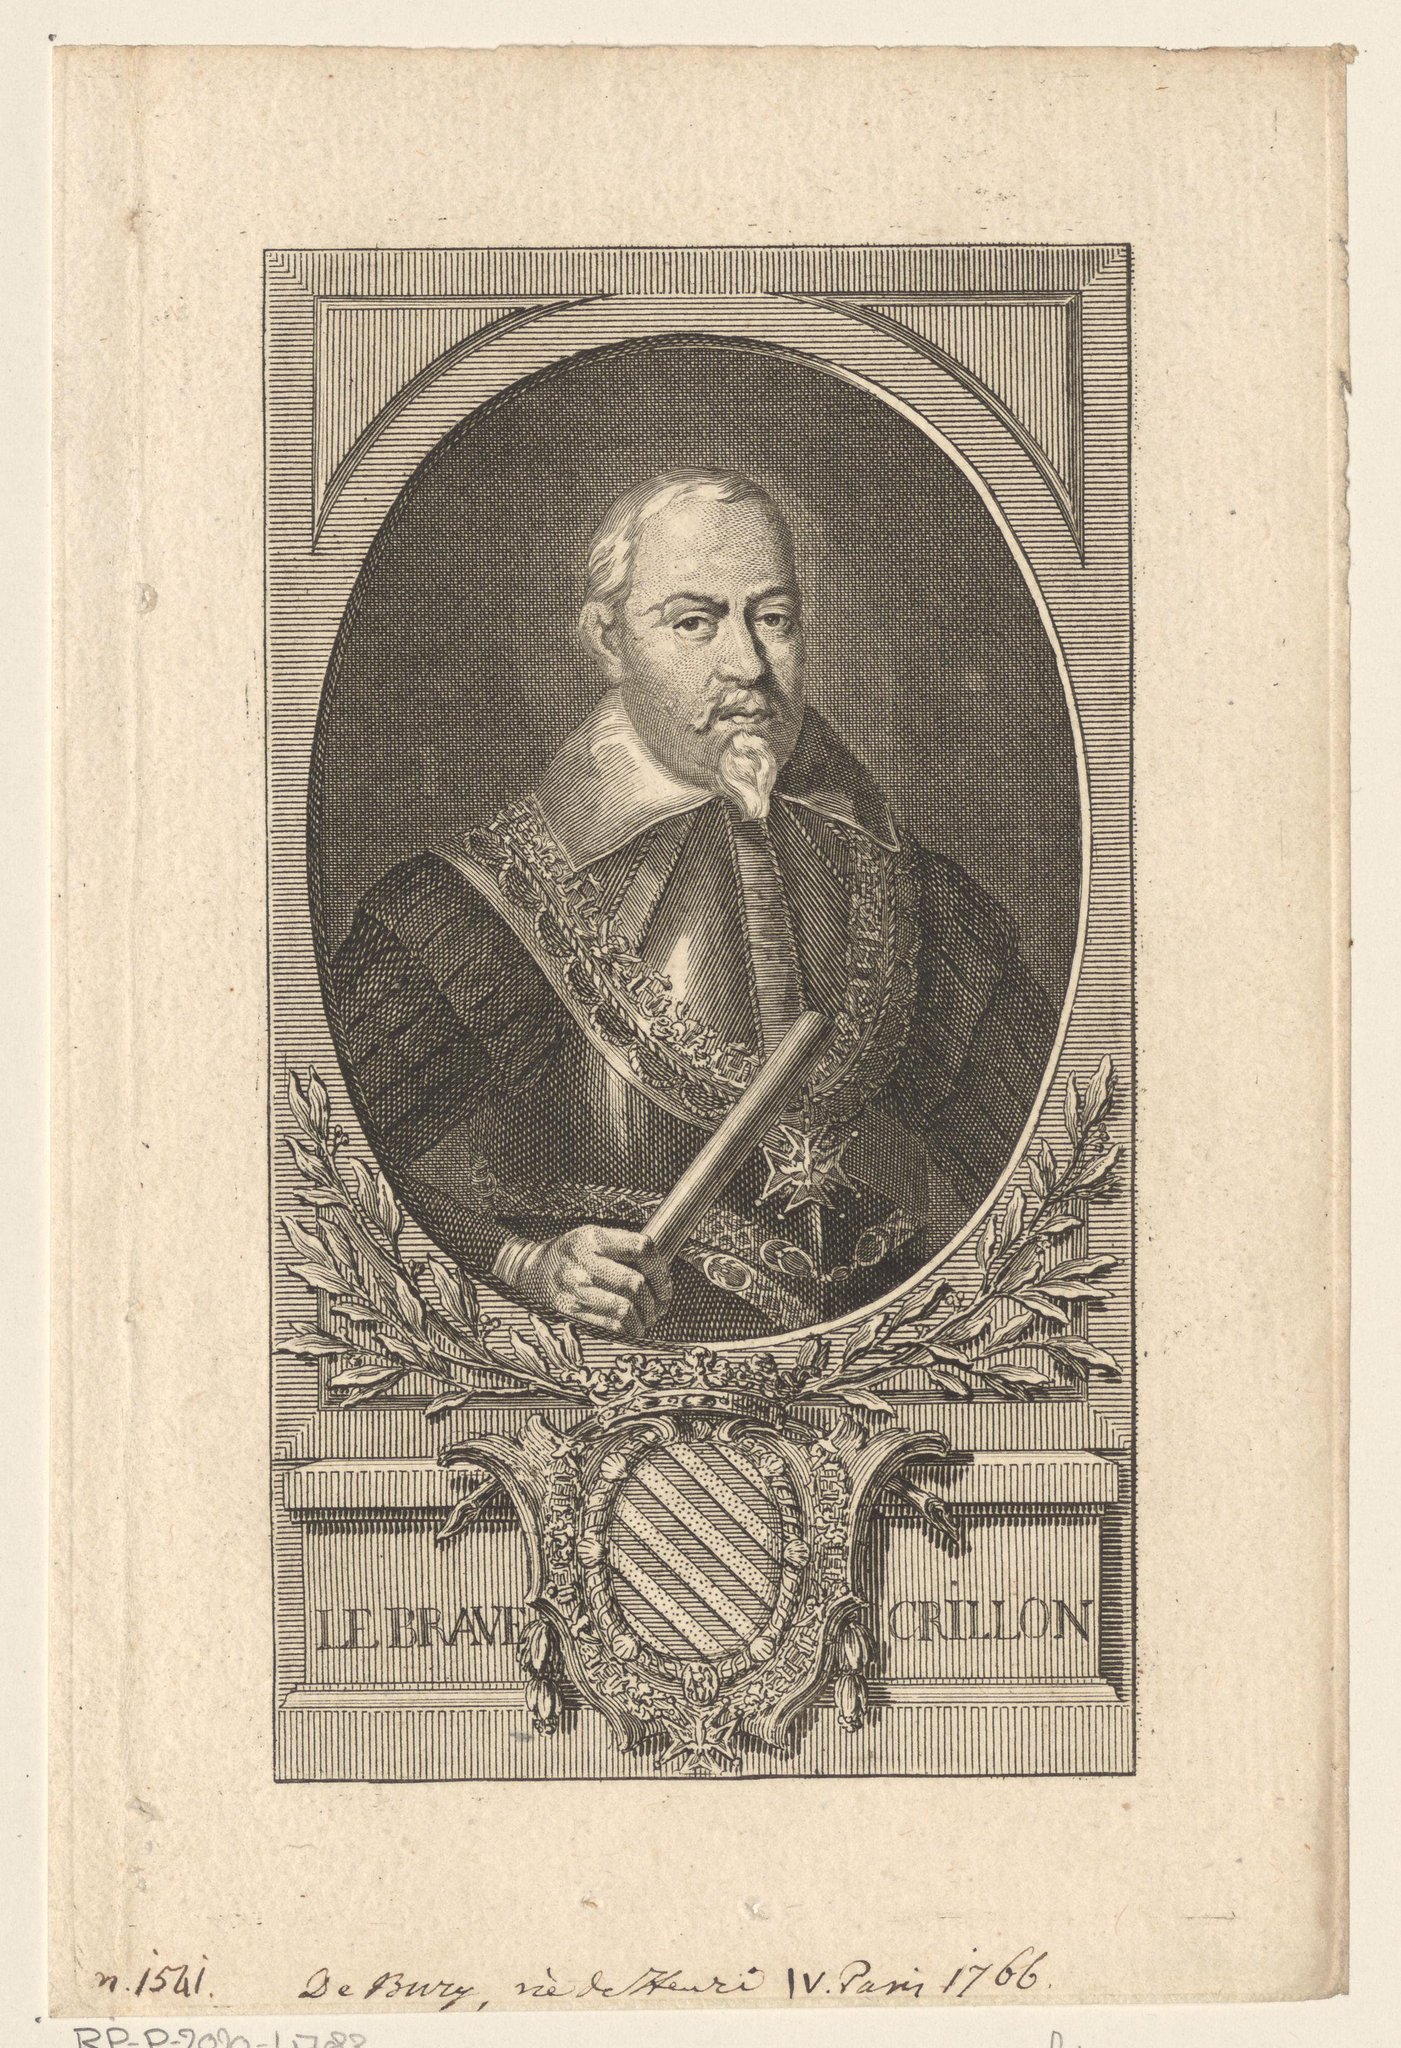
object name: print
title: Portret van Louis des Balbes de Berton de Crillon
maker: Anonymous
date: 1700-1799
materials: paper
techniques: engraving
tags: historical persons